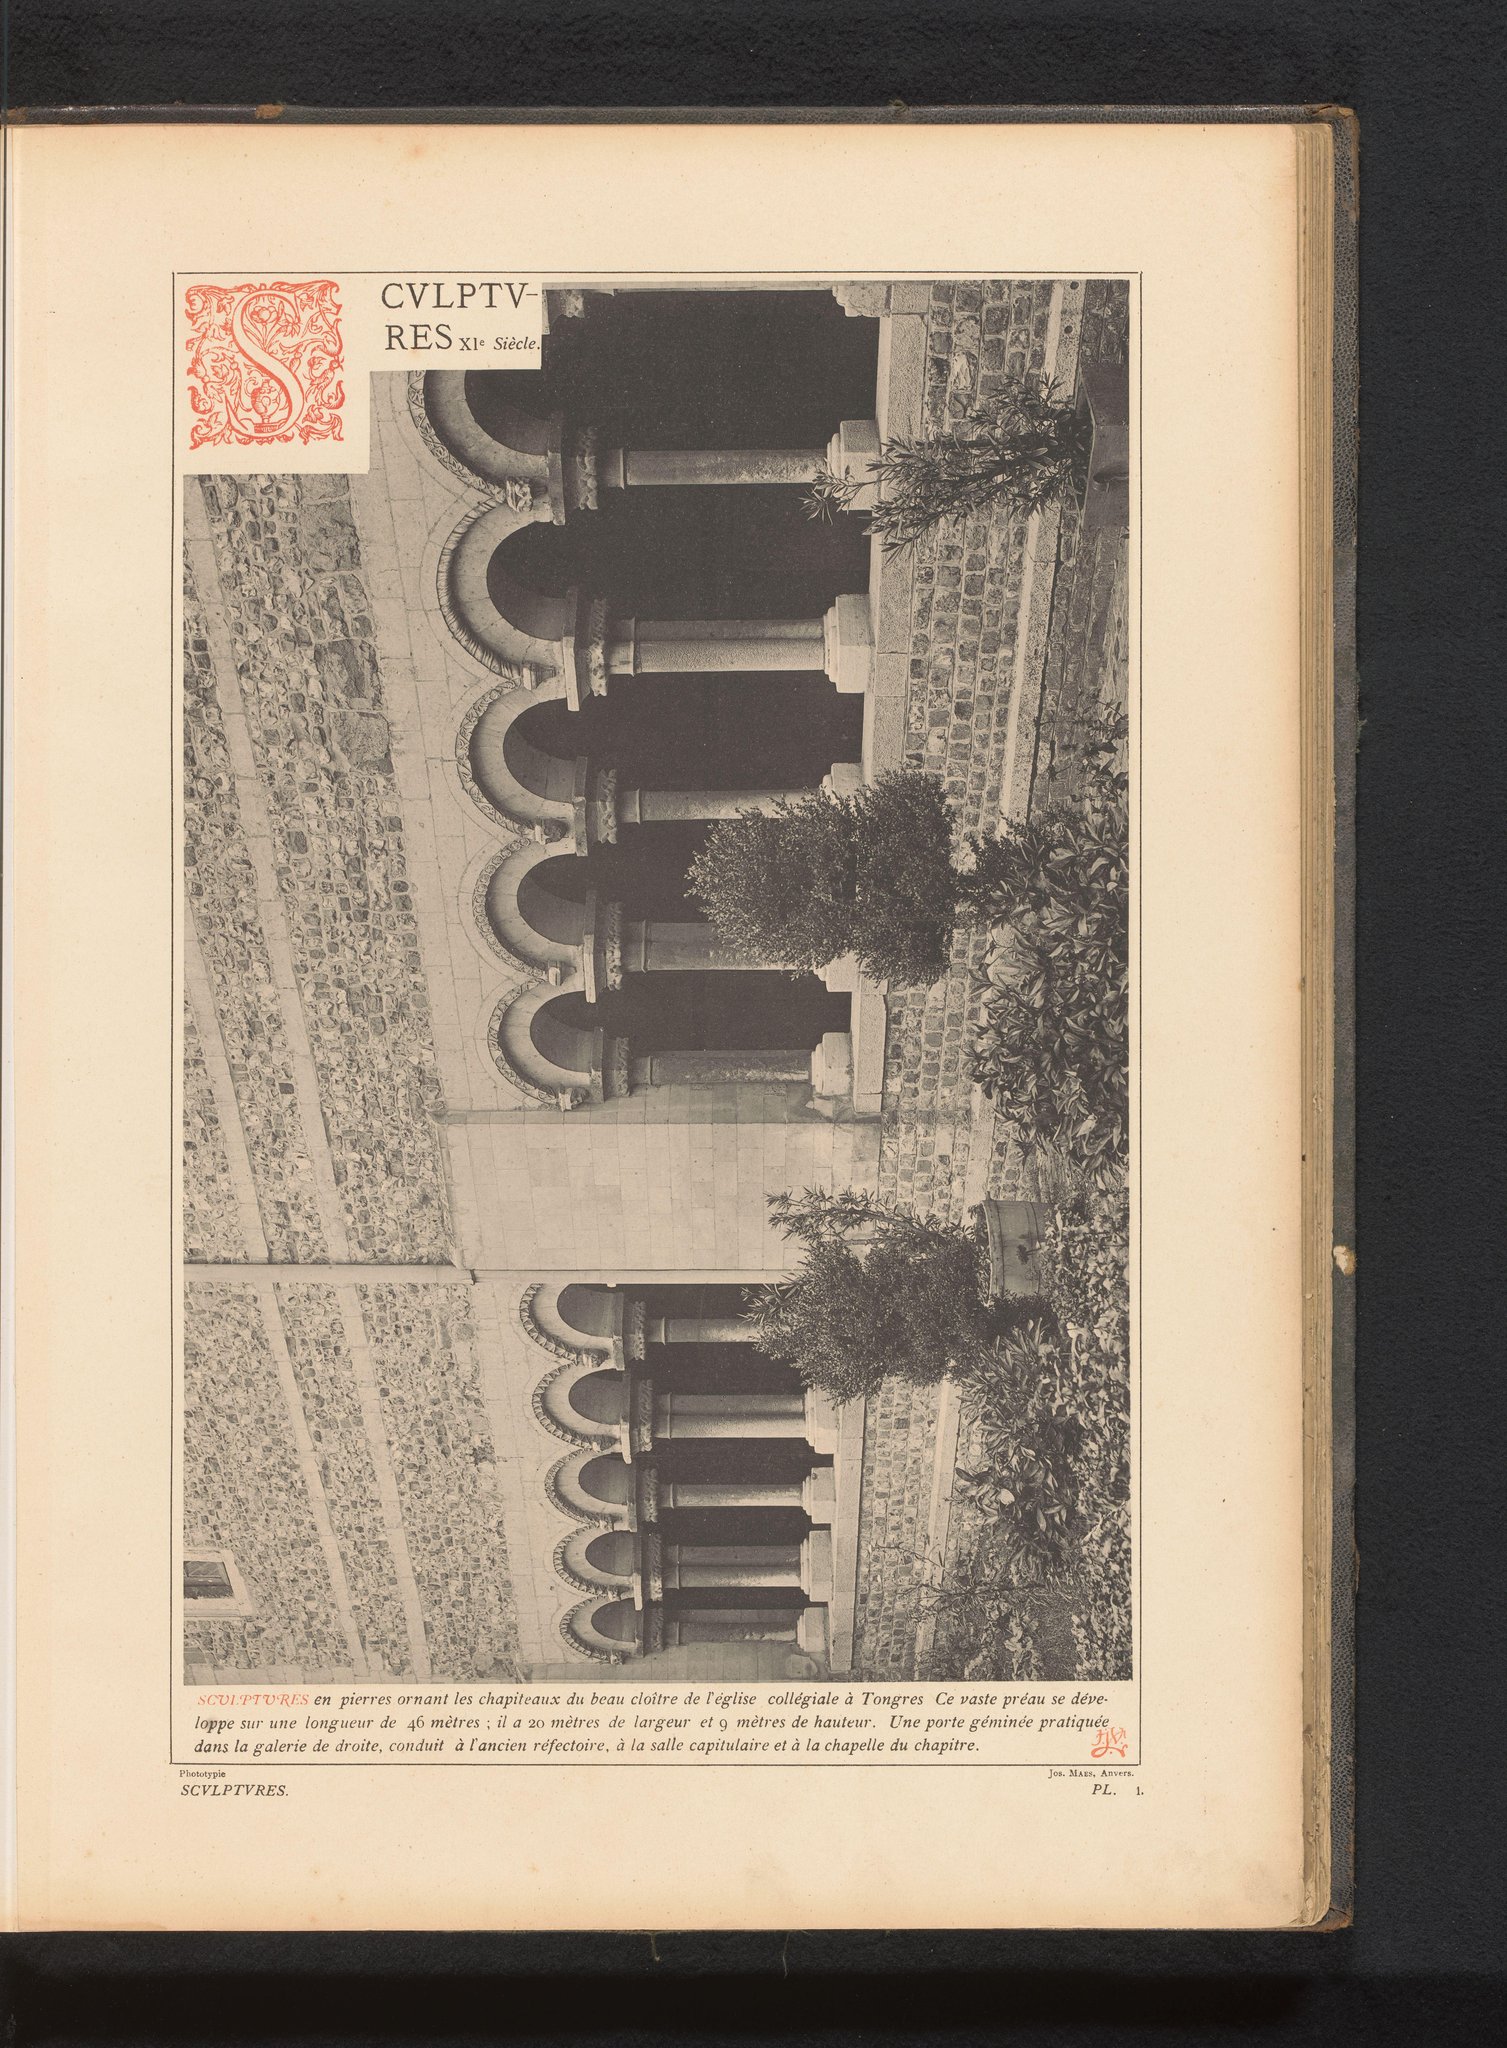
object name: page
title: Sculptures XIe, Siècle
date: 1881-1889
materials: paper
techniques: photograph, photolithography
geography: antwerp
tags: cloisters ~ monastery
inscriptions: inscription: ‘SCULPTURES. PL. 1.’, monogram: ‘JJvY’, inscription: ‘SCULPTURES en pierres (...)’